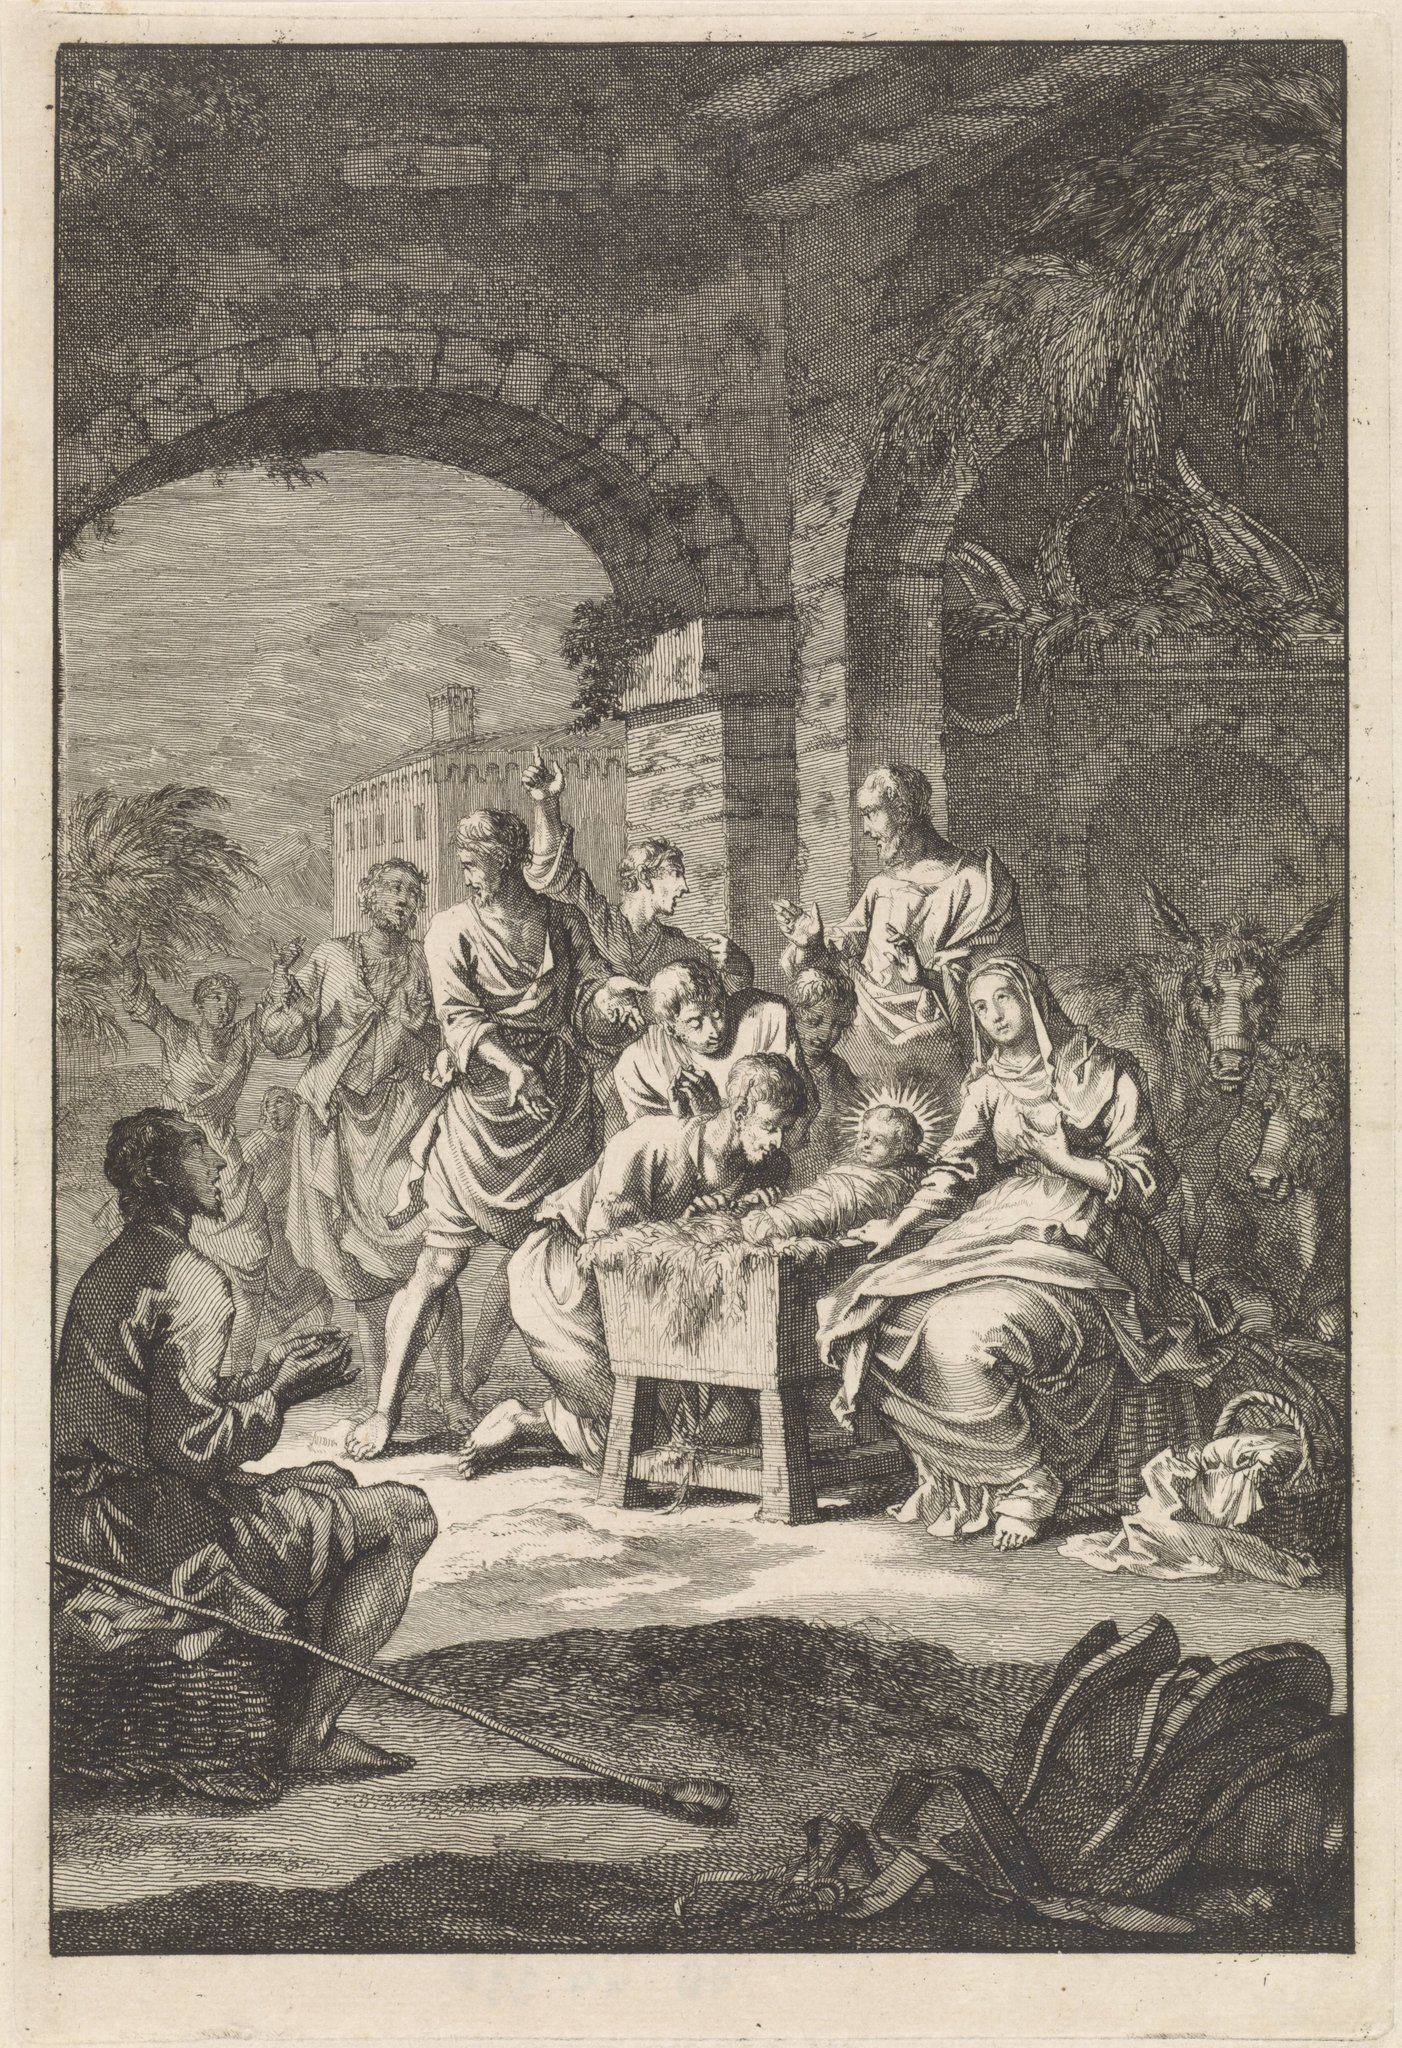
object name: print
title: Aanbidding der herders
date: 1700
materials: paper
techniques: etching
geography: amsterdam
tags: adoration of the christ-child by the shepherds; mary and joseph present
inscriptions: caption: ‘Historie van onzen saligmaker Jesus Christus door jeremias Taylor by W. Broedelet v100 18vt to 19’, collector's mark: Lugt 2228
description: Proefdruk van een boekillustratie voor Jeremy Taylor. Historie van't leven en de doot van onsen saligmaker Jesus Christus. Deel I. Amsterdam: Willem Broedelet, 1700, p. 19.